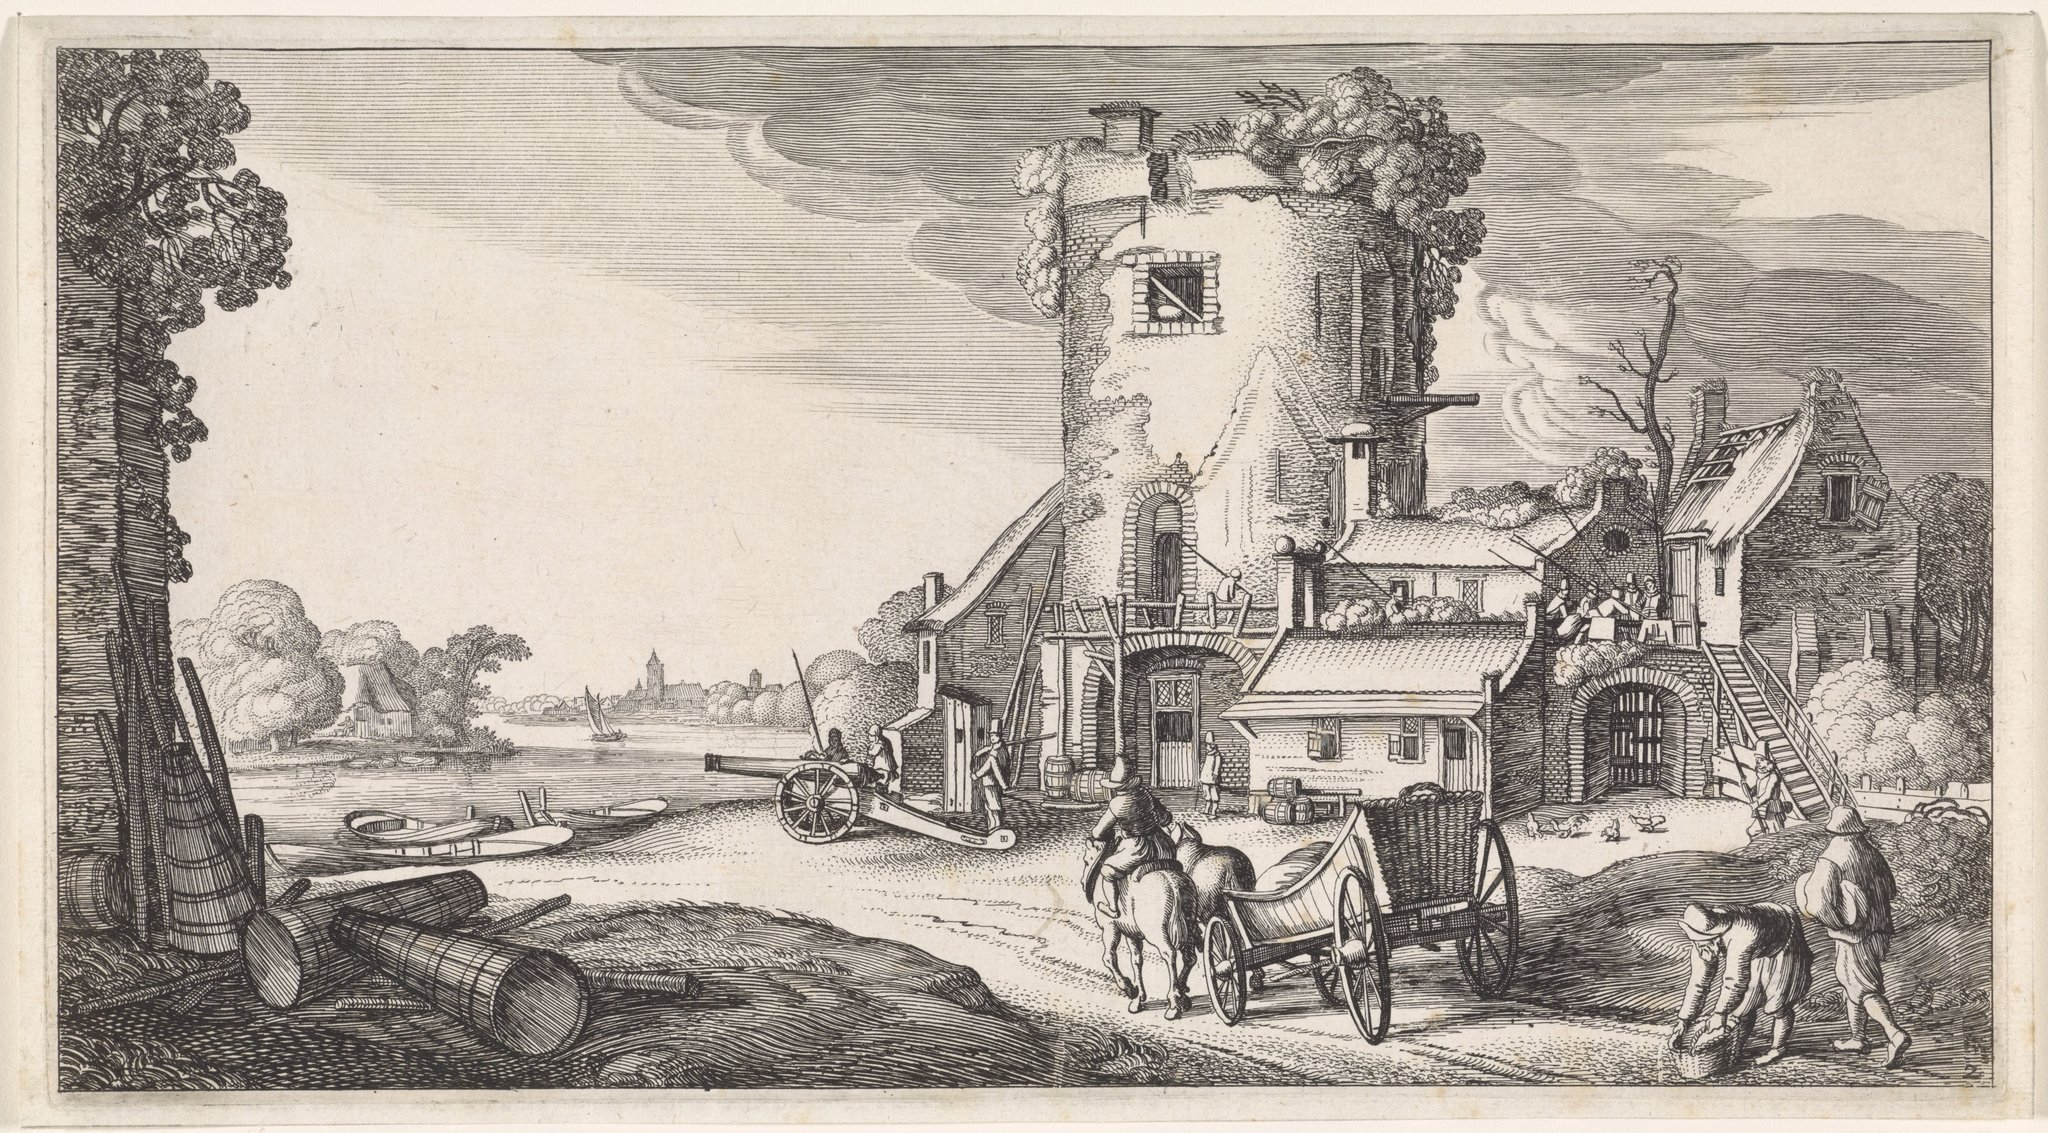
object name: print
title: Soldaten bij een toren in een rivierlandschap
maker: jan van de velde (ii)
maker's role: draughtsman, painter, print maker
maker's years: 1593-1641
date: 1639-1641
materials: paper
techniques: etching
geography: northern netherlands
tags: river, landscape with tower or castle, the soldier; the soldier's life, (farm) wagon, freight wagon, cart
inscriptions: collector's mark: Lugt 964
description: Soldaten bij een toren in een rivierlandschap. Op de voorgrond een kar getrokken door twee paarden. Bij de toren een kanon. Tweede prent van een serie met 36 prenten van landschappen, verdeeld over zes delen.